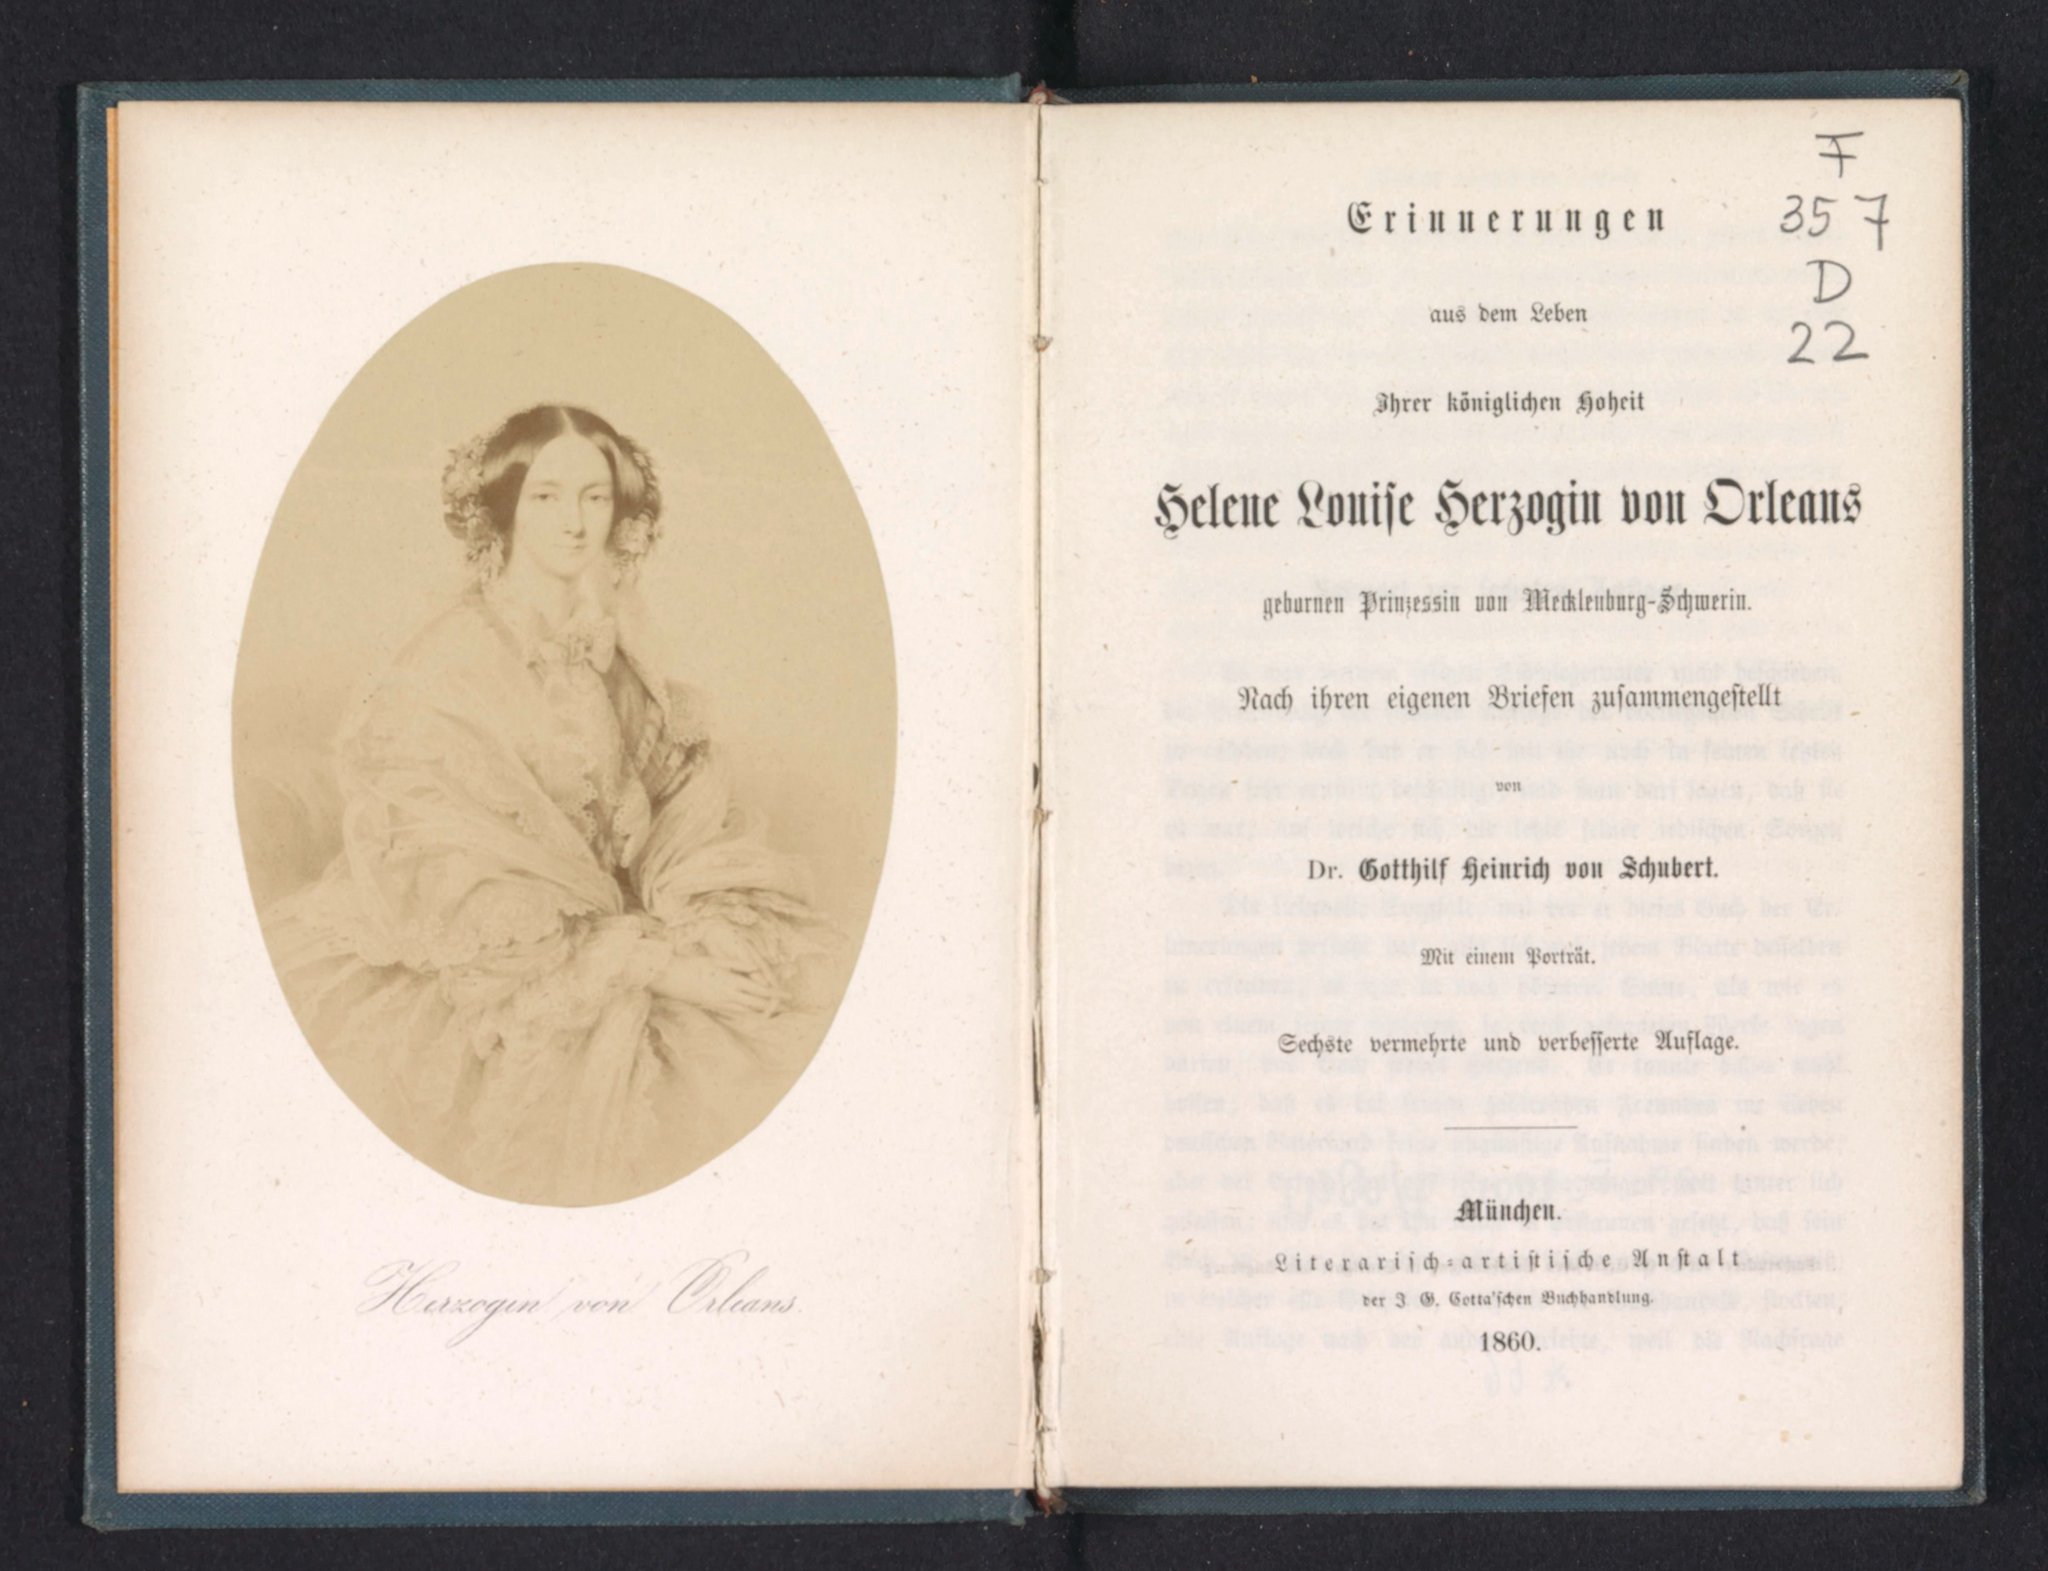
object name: book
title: Erinnerungen aus dem Leben Ihrer königlichen Hoheit Helene Louise Herzogin von Orleans gebornen Prinsessin von Mecklenburg-Schwerin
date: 1860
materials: cardboard, linen, paper, photographic support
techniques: albumen print, printing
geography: munich